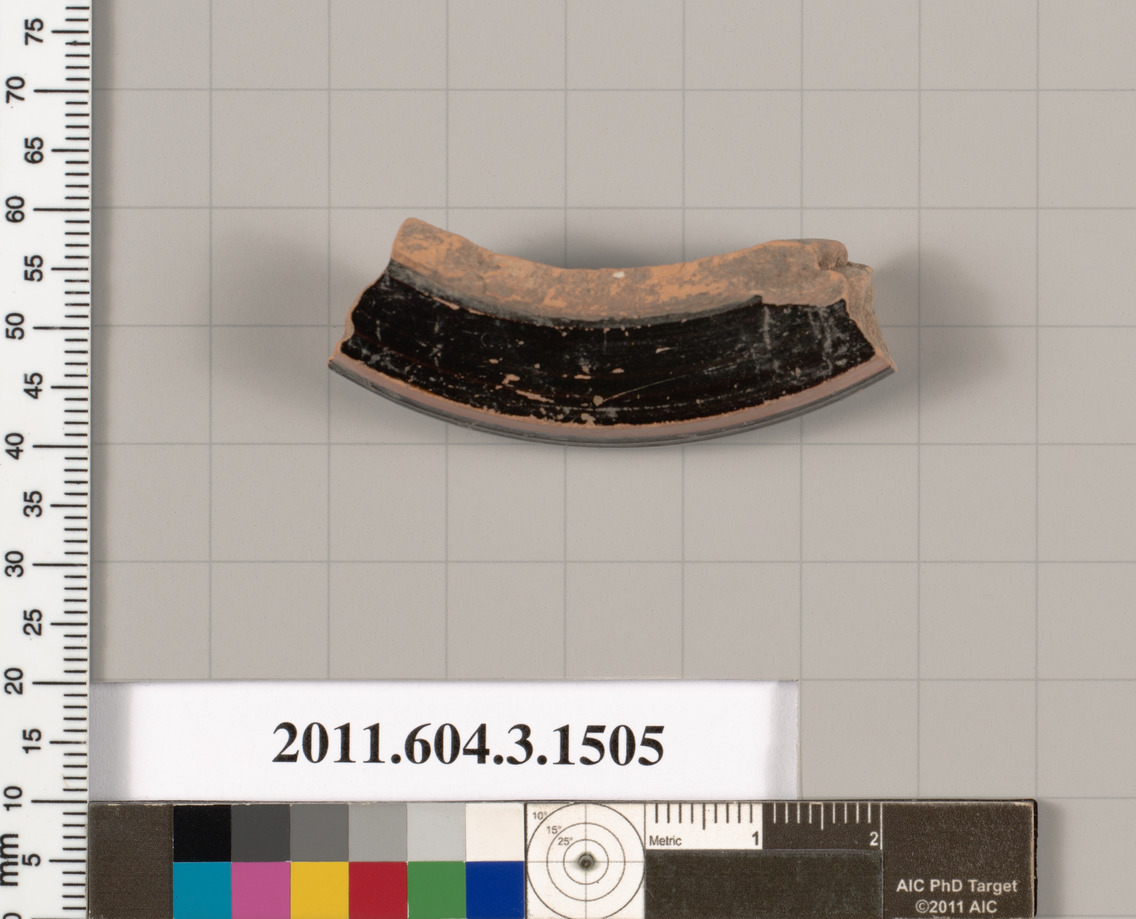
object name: skyphos fragment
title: Terracotta fragment of a skyphos (deep drinking cup)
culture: greek, attic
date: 600-401 BCE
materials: terracotta